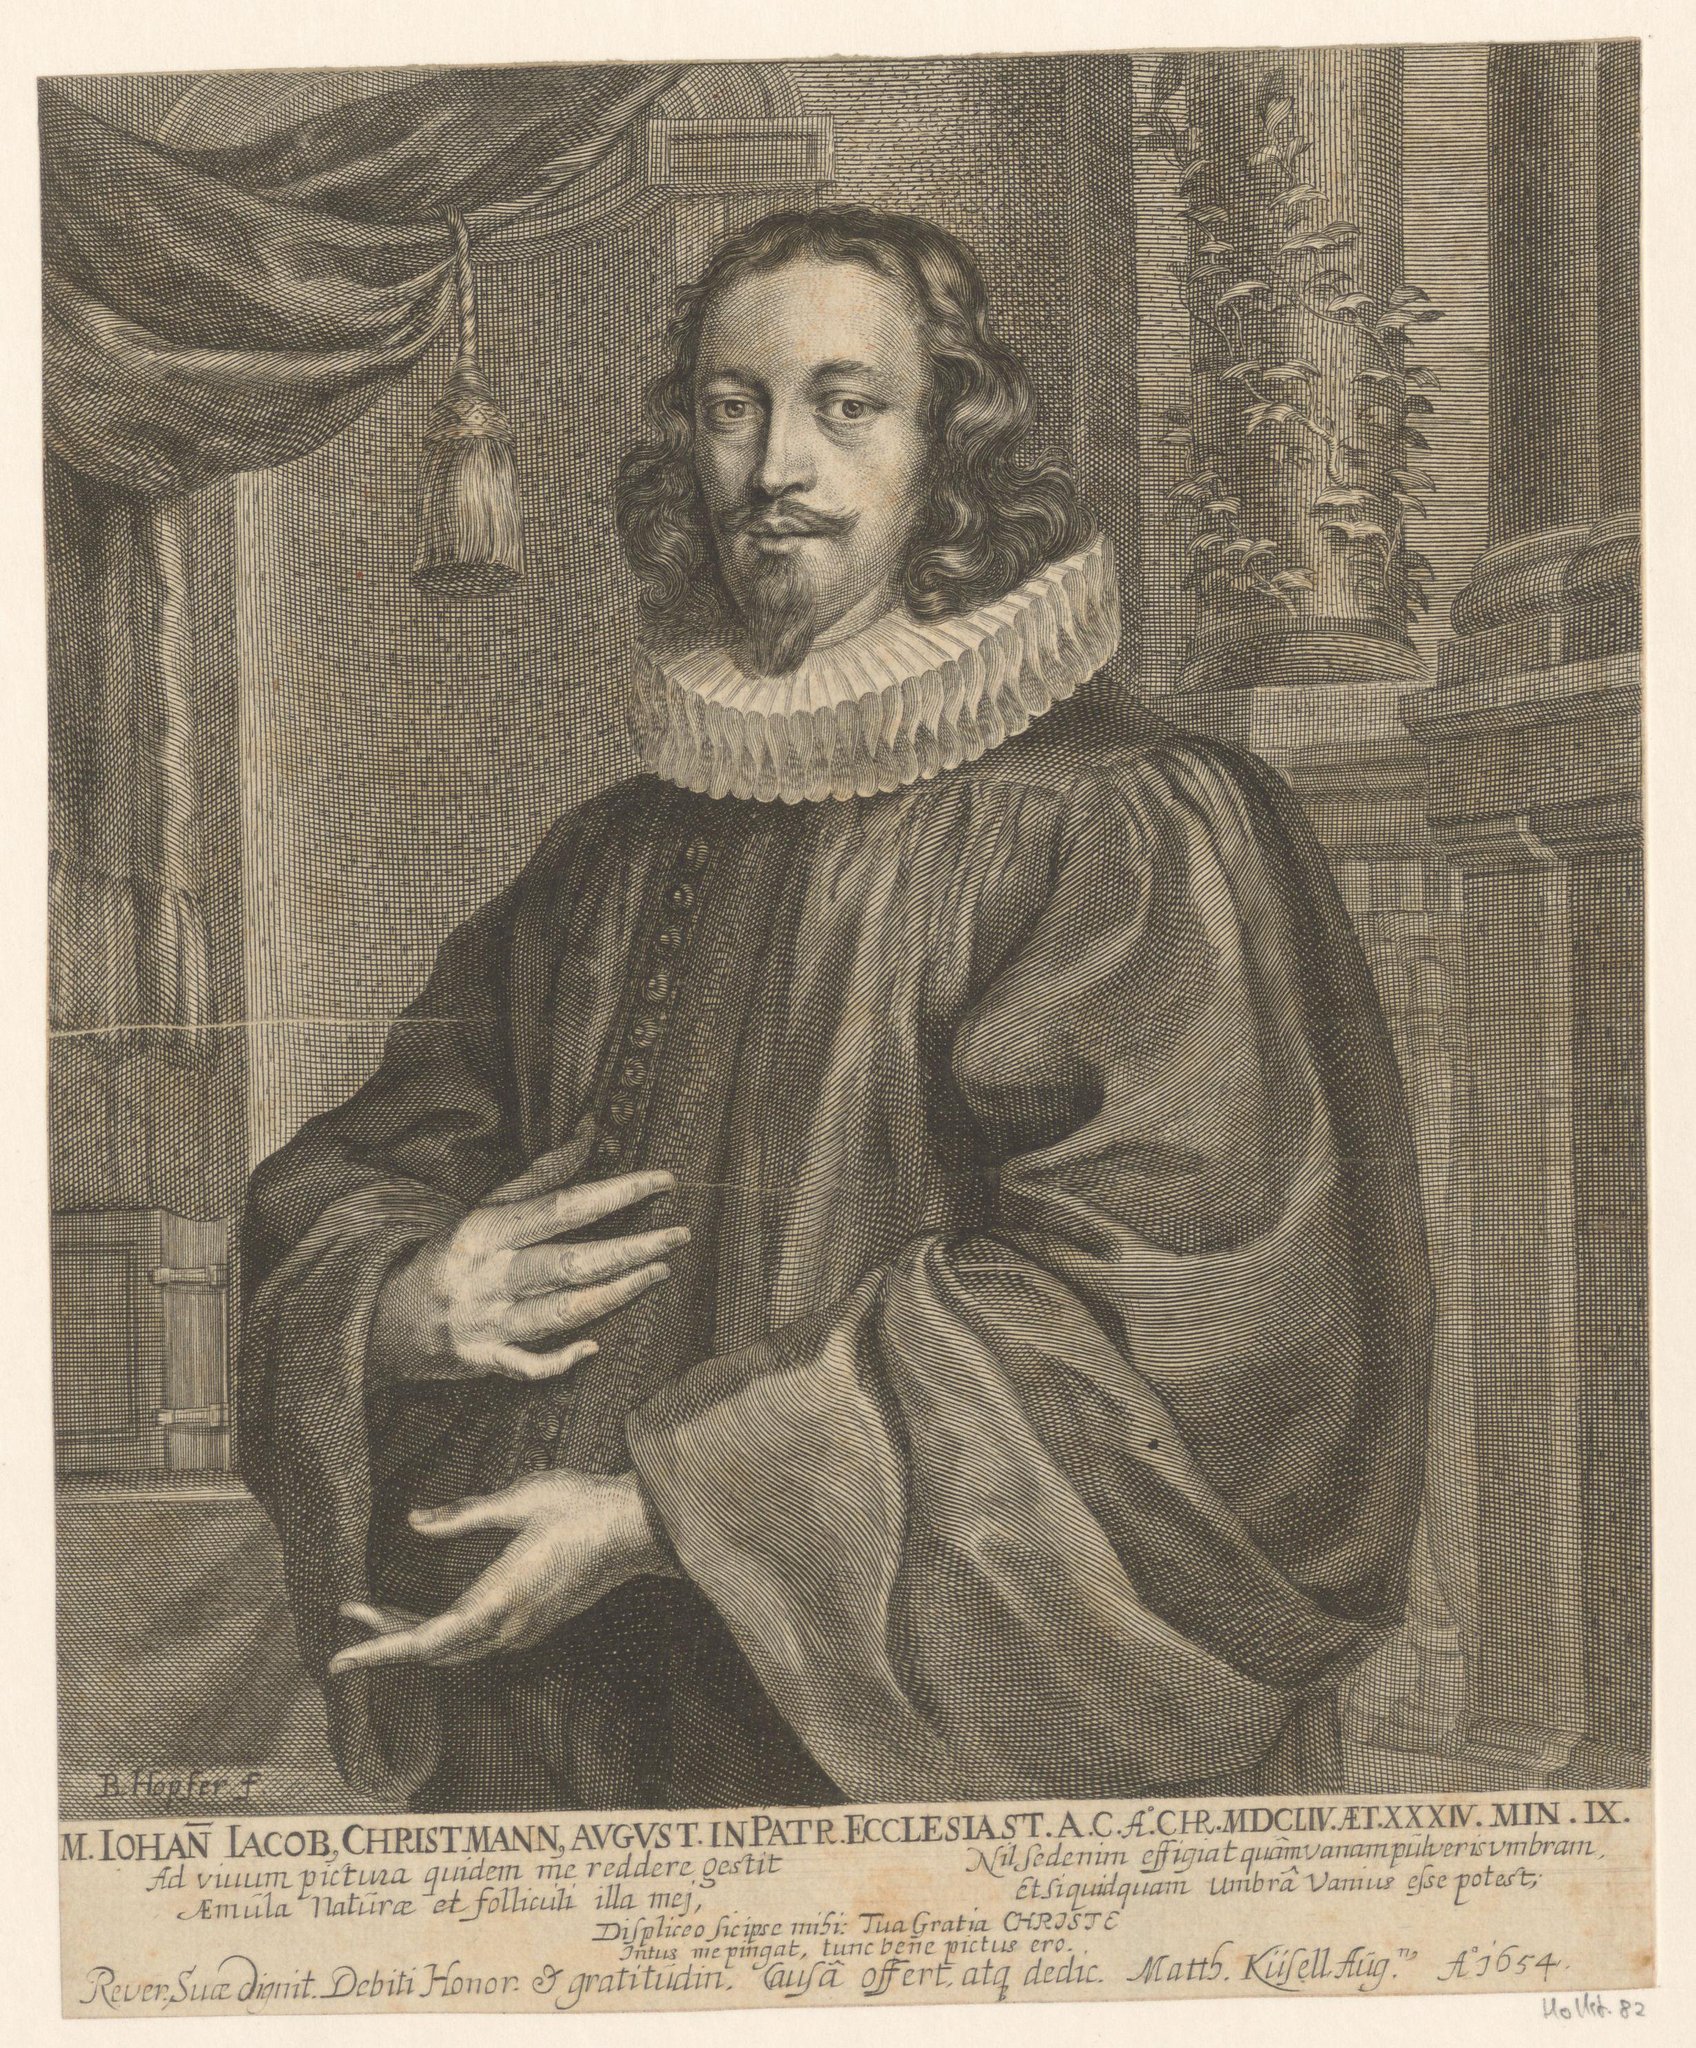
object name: print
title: Portret van Johann Jacob Christmann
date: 1654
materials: paper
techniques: engraving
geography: augsburg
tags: johann jacob christmann, theologian, historical persons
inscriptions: collector's mark: Lugt 2228, collector's mark: Lugt 9